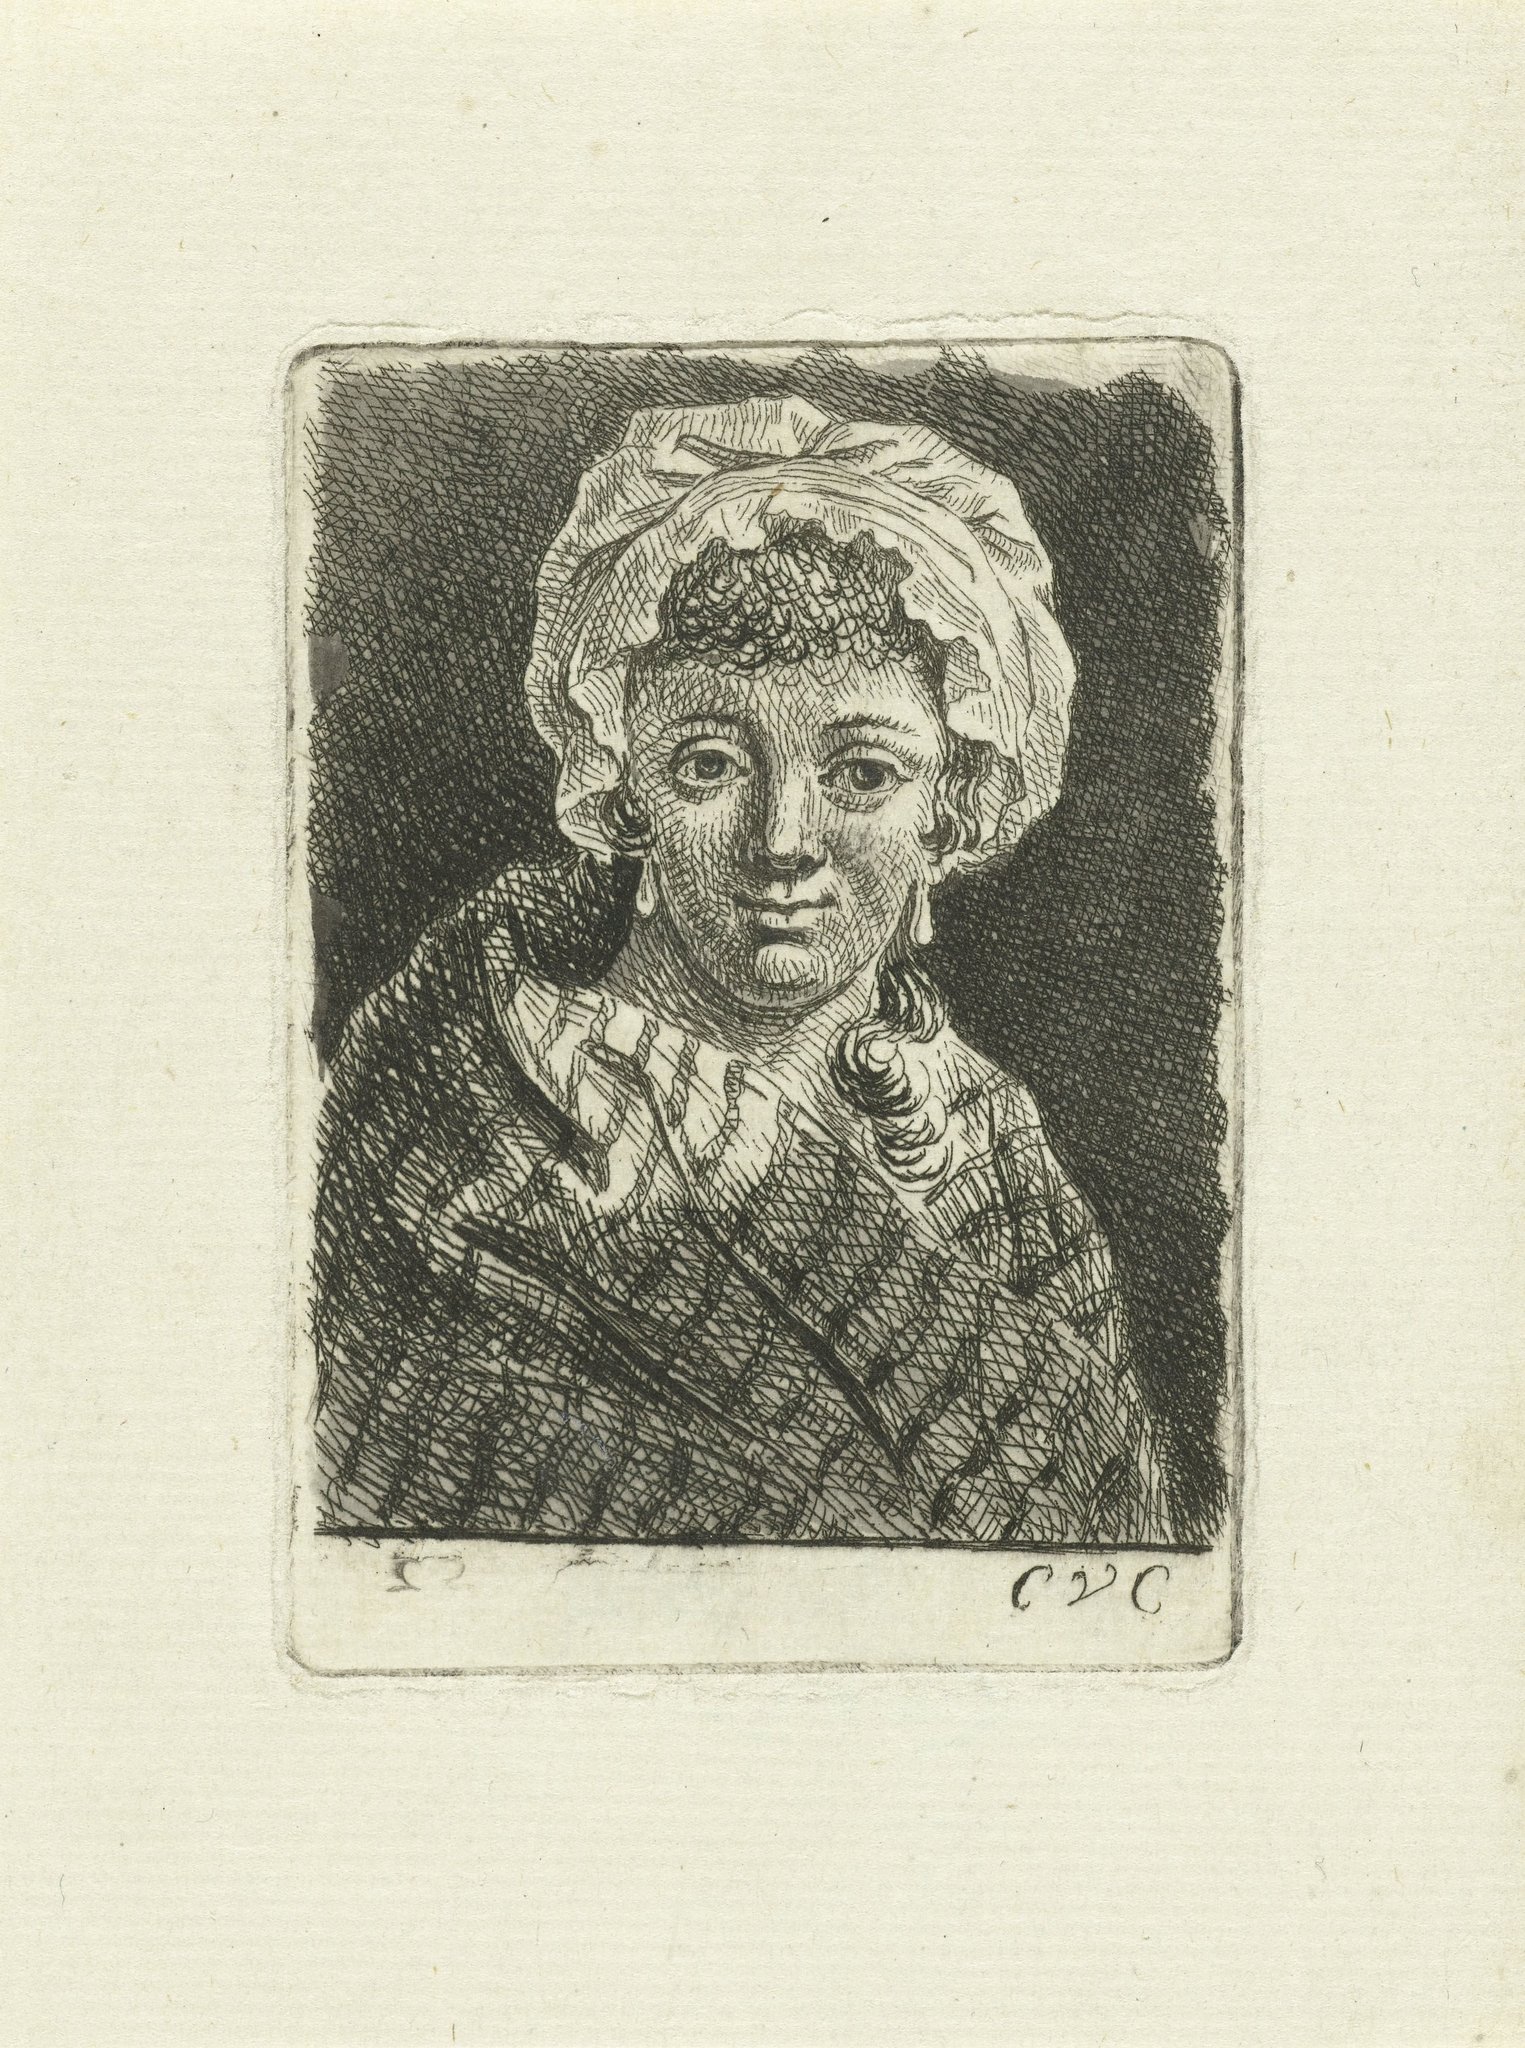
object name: print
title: Jonge vrouw met muts en krullend haar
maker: cornelis van cuijlenburgh (ii)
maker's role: painter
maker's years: 1758-1827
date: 1768-1827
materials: paper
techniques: etching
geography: netherlands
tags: adolescent, young woman, maiden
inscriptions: collector's mark: Lugt 2228